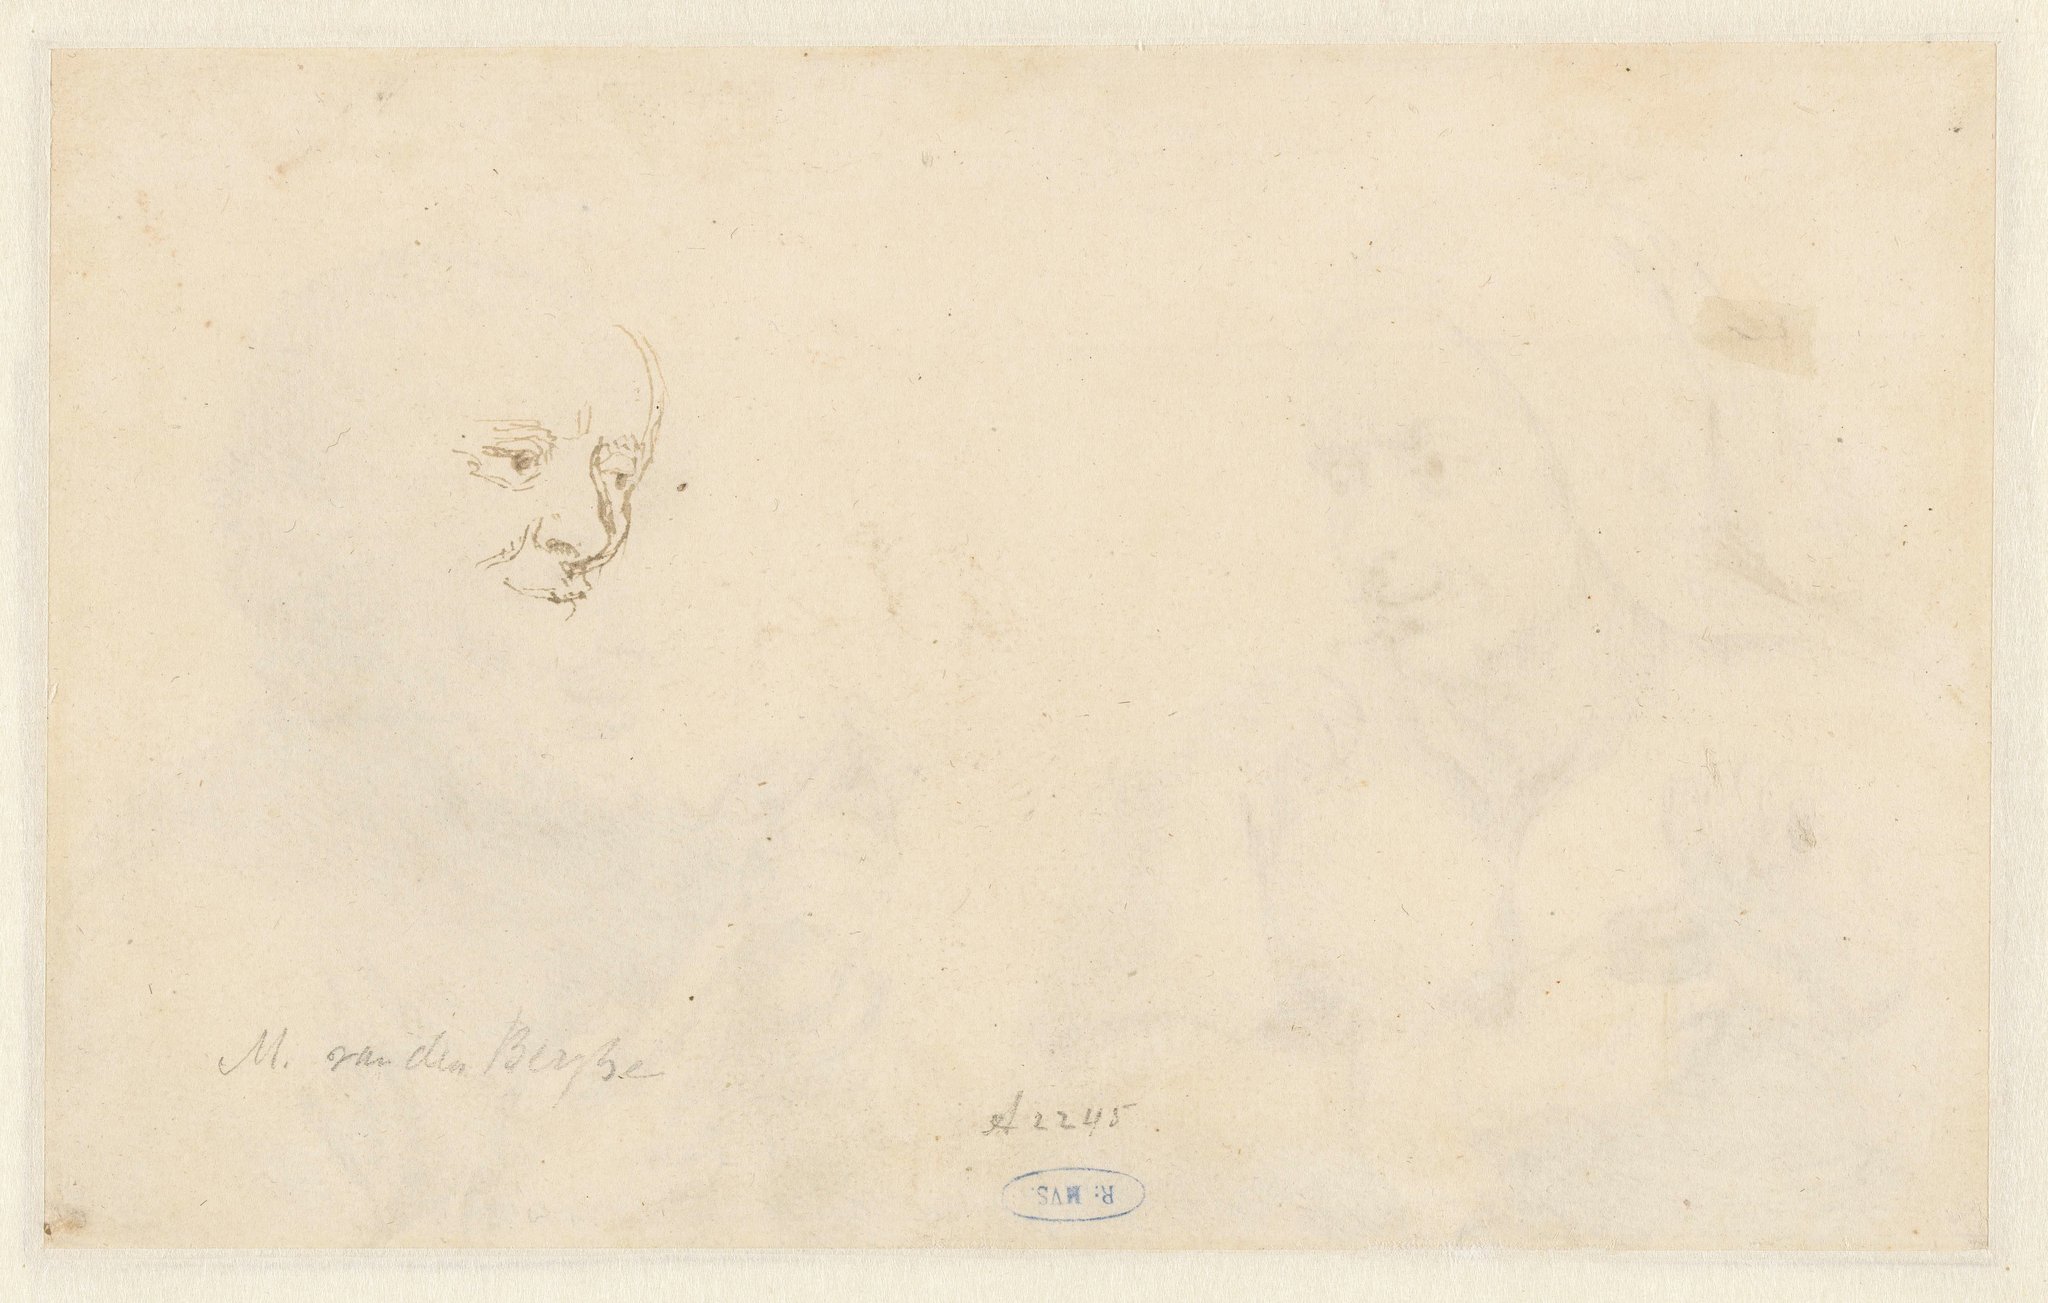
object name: drawing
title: Schets van een gezicht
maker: matthys van den bergh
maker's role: draughtsman, print maker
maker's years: 1617-1687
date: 1677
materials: ink, paper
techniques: pen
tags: face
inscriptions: date